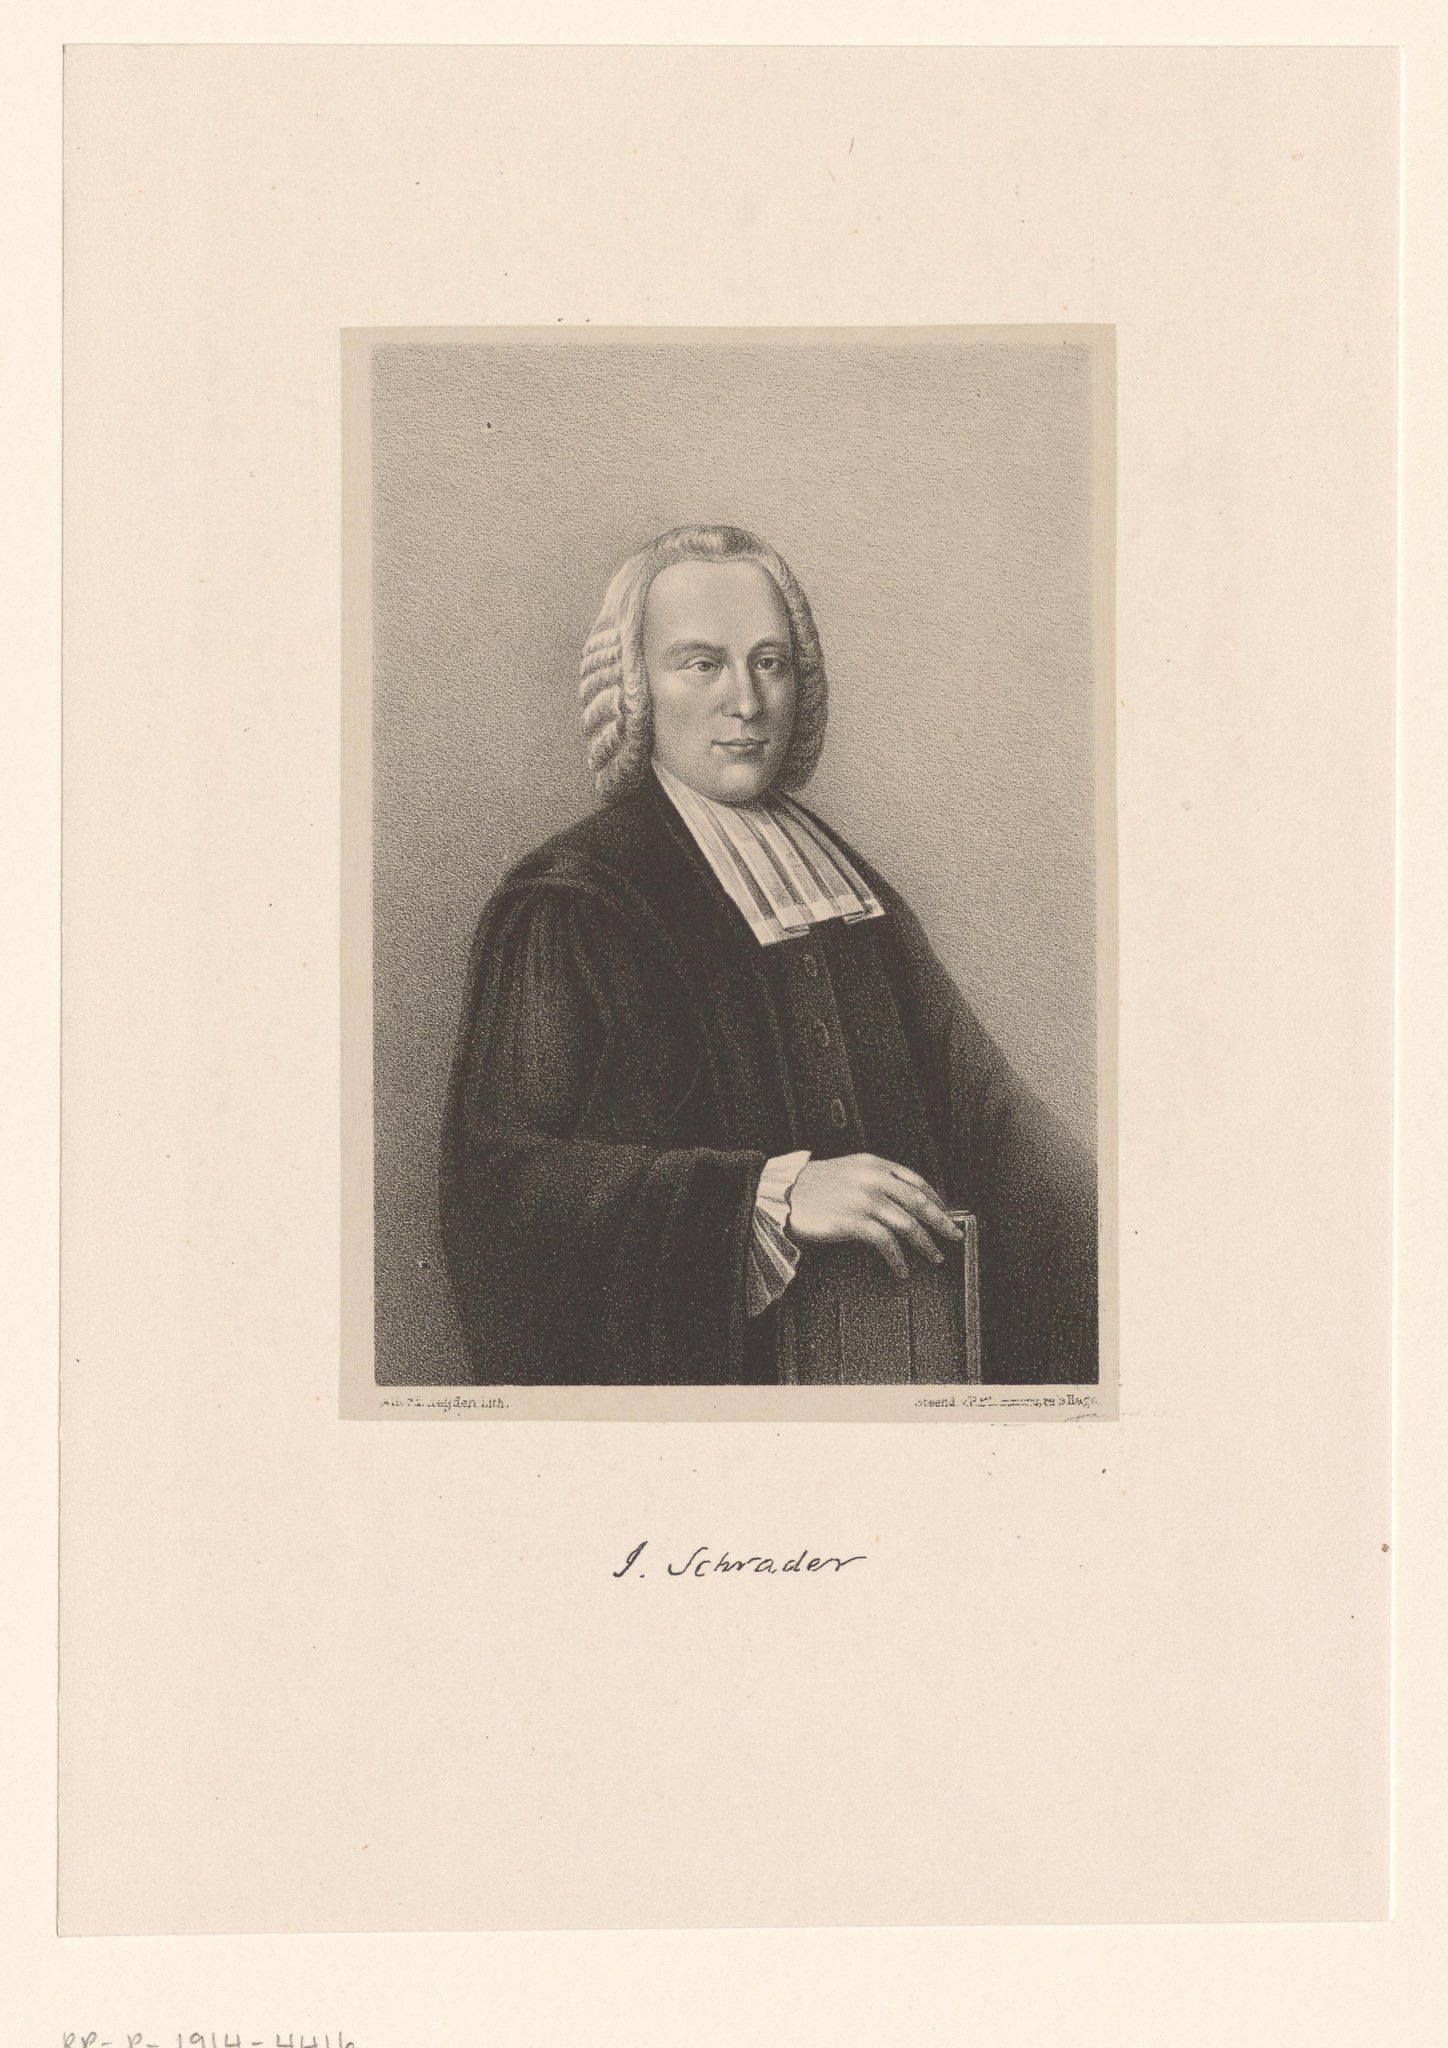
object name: print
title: Portret van Johannes Schrader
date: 1842-1887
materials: paper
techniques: lithograph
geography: the hague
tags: johannes schrader, historical persons, professor